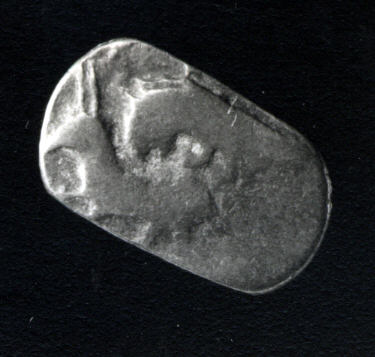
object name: coin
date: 1101-1300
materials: copper